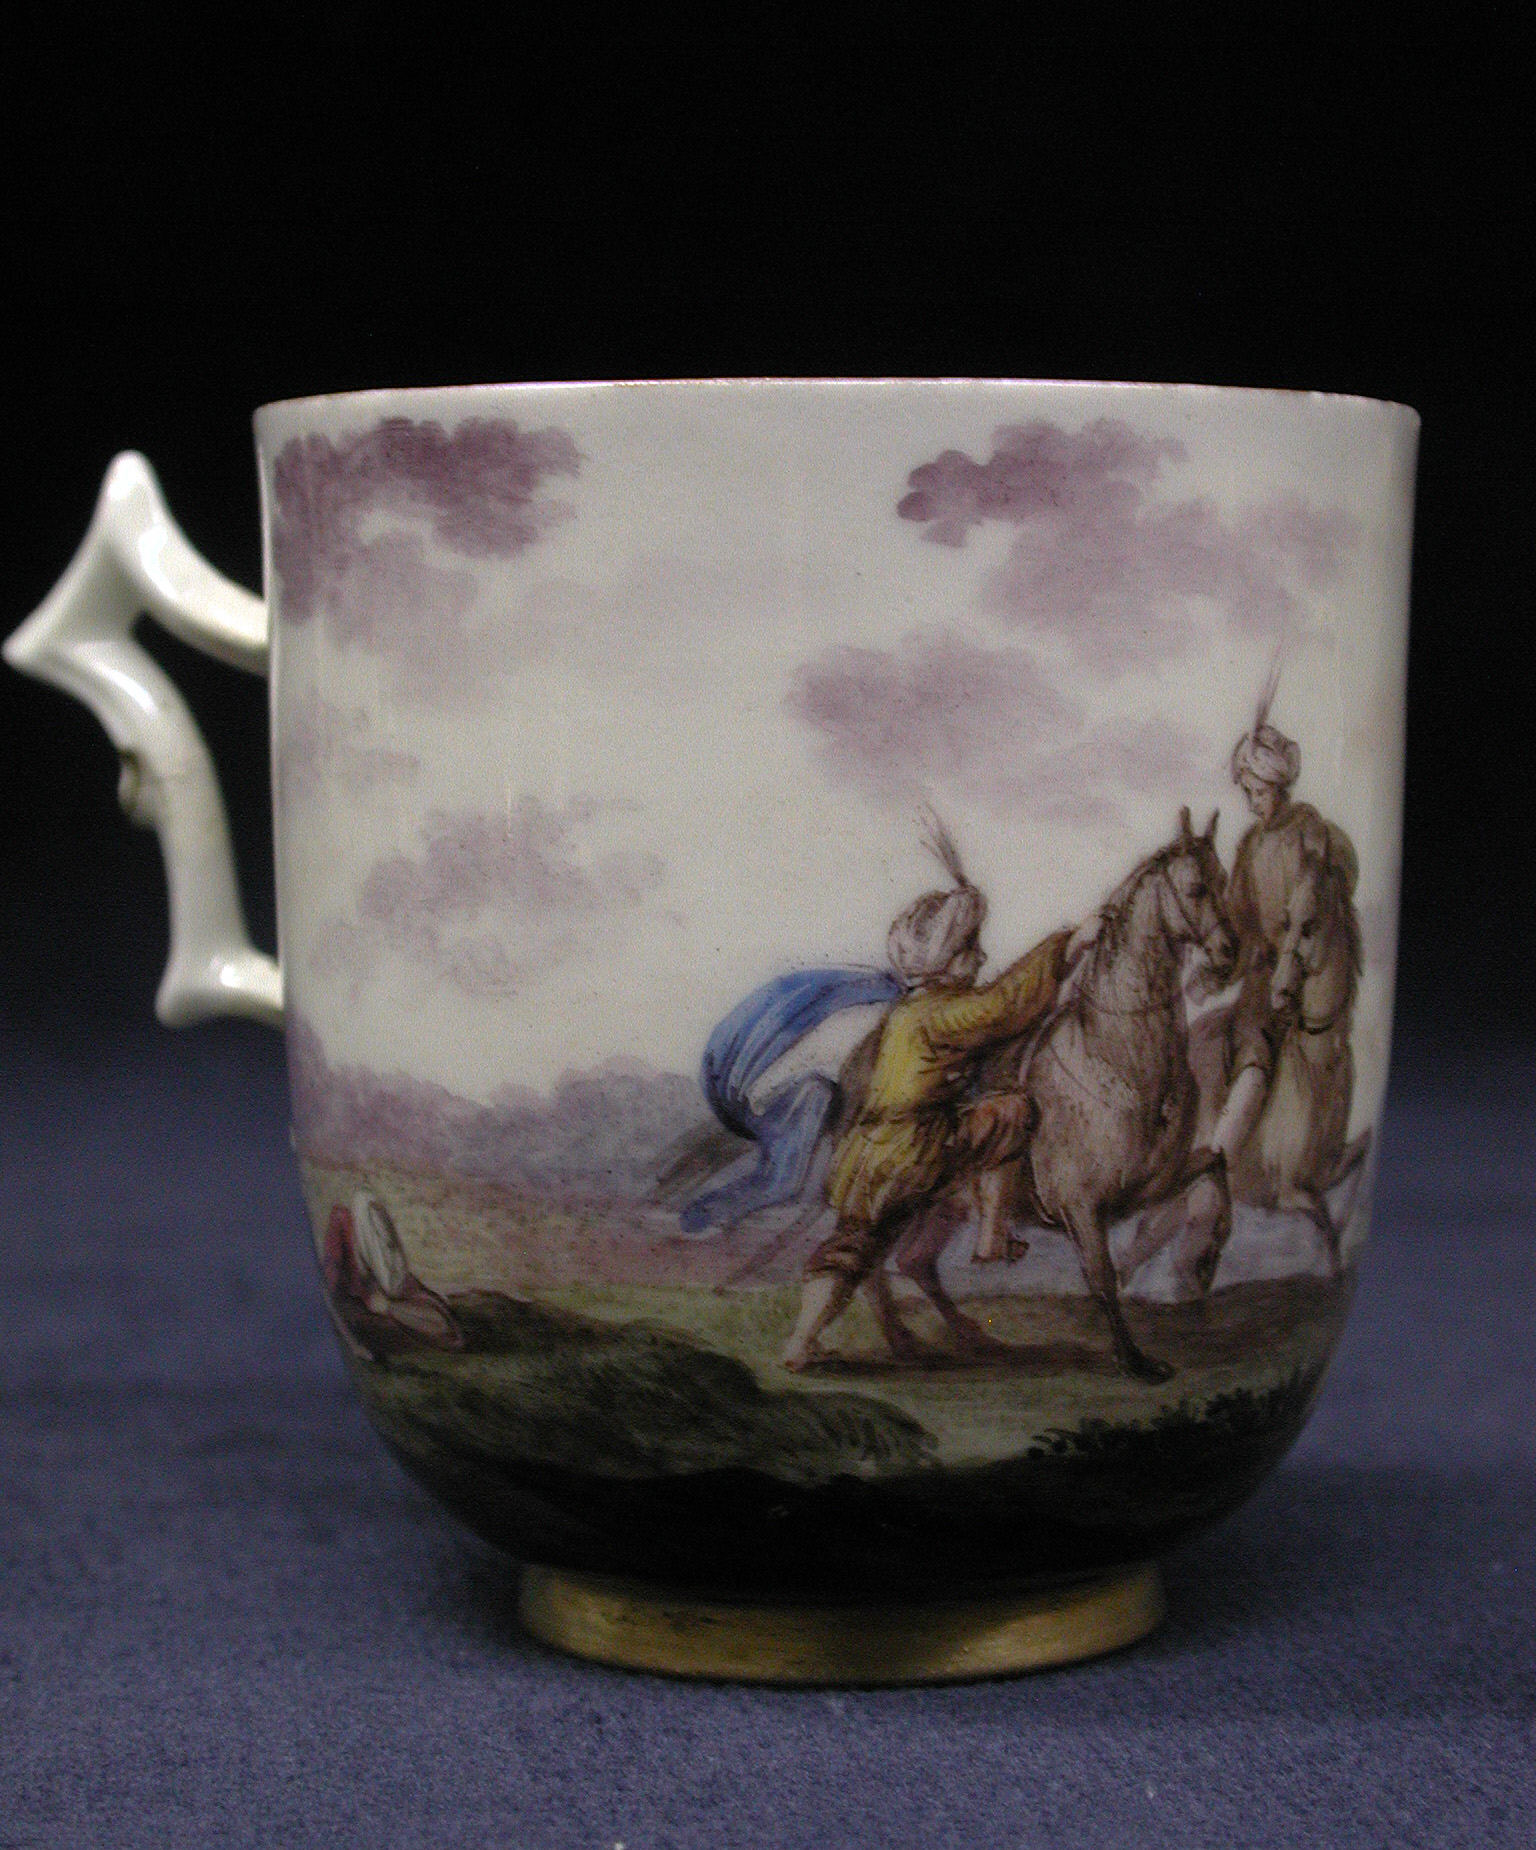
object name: cup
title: Cup (part of a service)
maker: capodimonte porcelain manufactory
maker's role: manufactory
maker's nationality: italian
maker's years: 1740-1759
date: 1743-1759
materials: soft paste porcelain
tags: men,horses